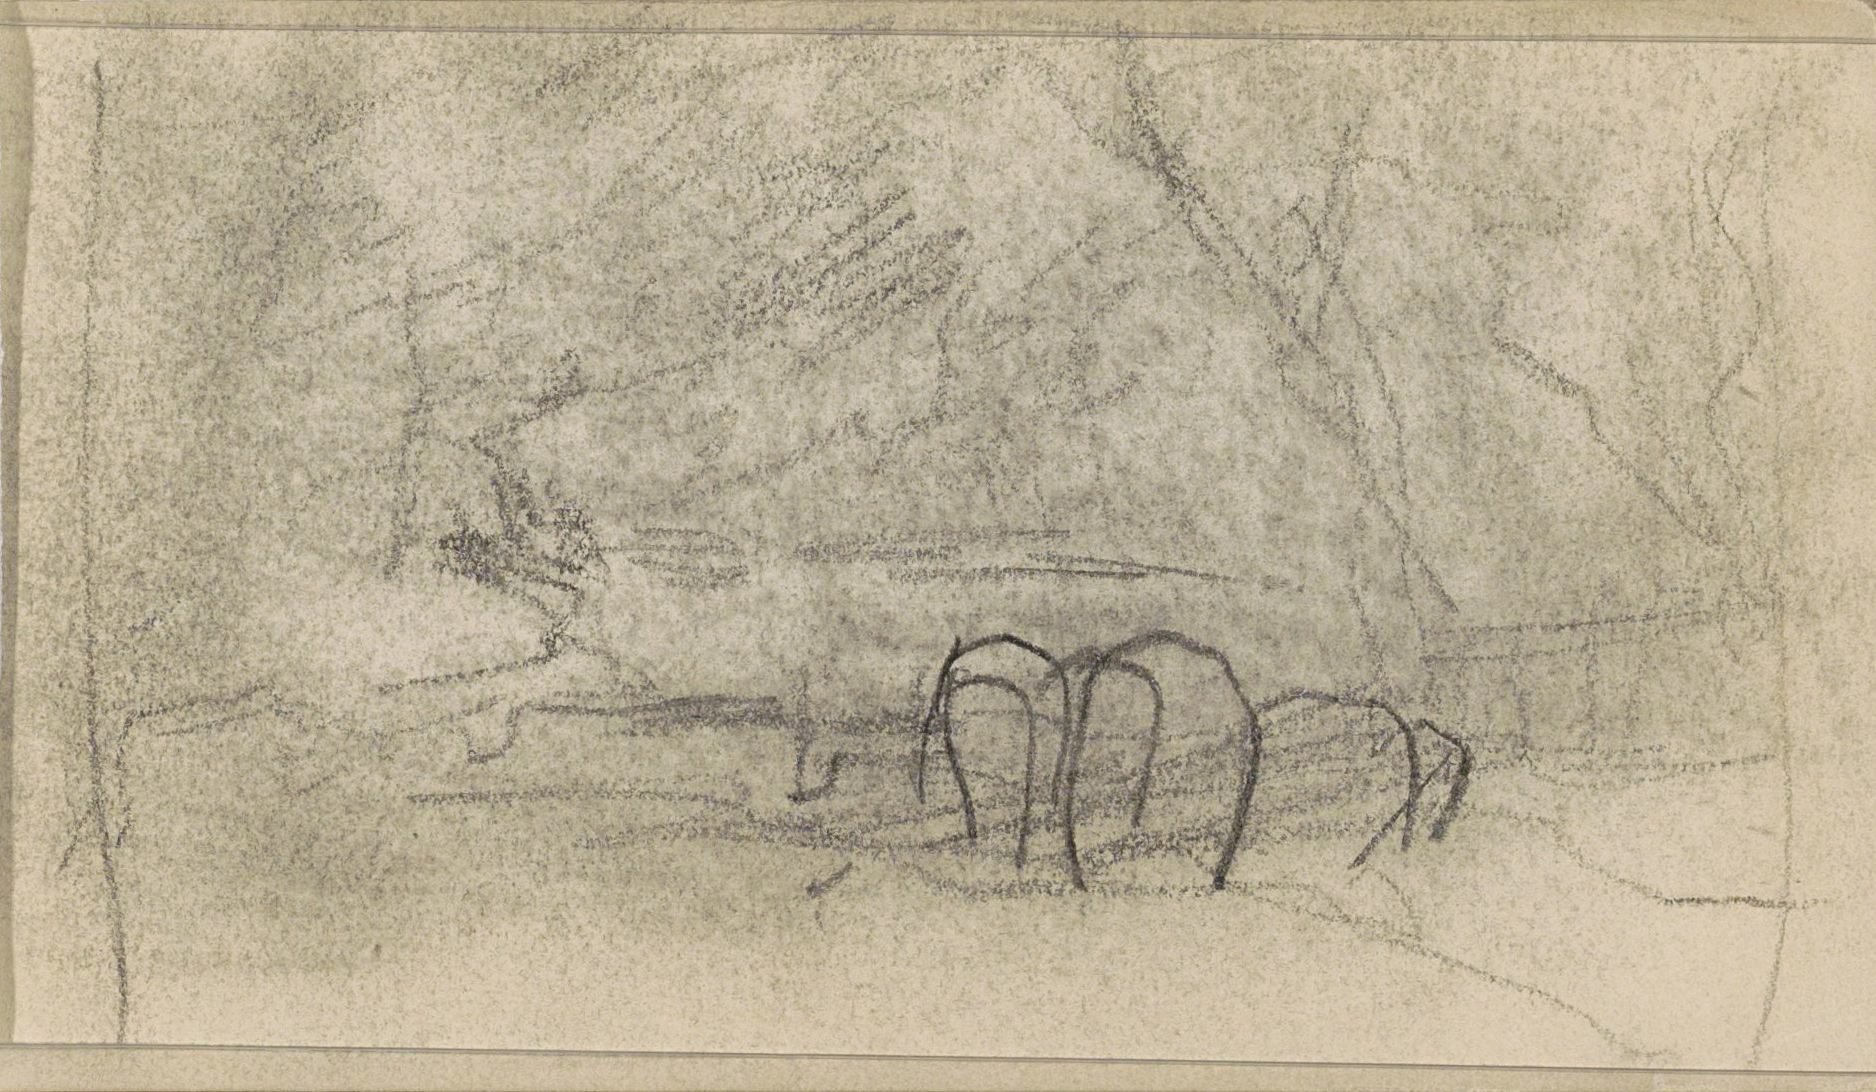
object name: sketchbook leaf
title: Landschap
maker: anton mauve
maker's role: draughtsman, painter, print maker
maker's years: 1838-1888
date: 1876-1879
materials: chalk, paper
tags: landscapes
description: Blad 9 recto uit een schetsboek met 33 bladen.